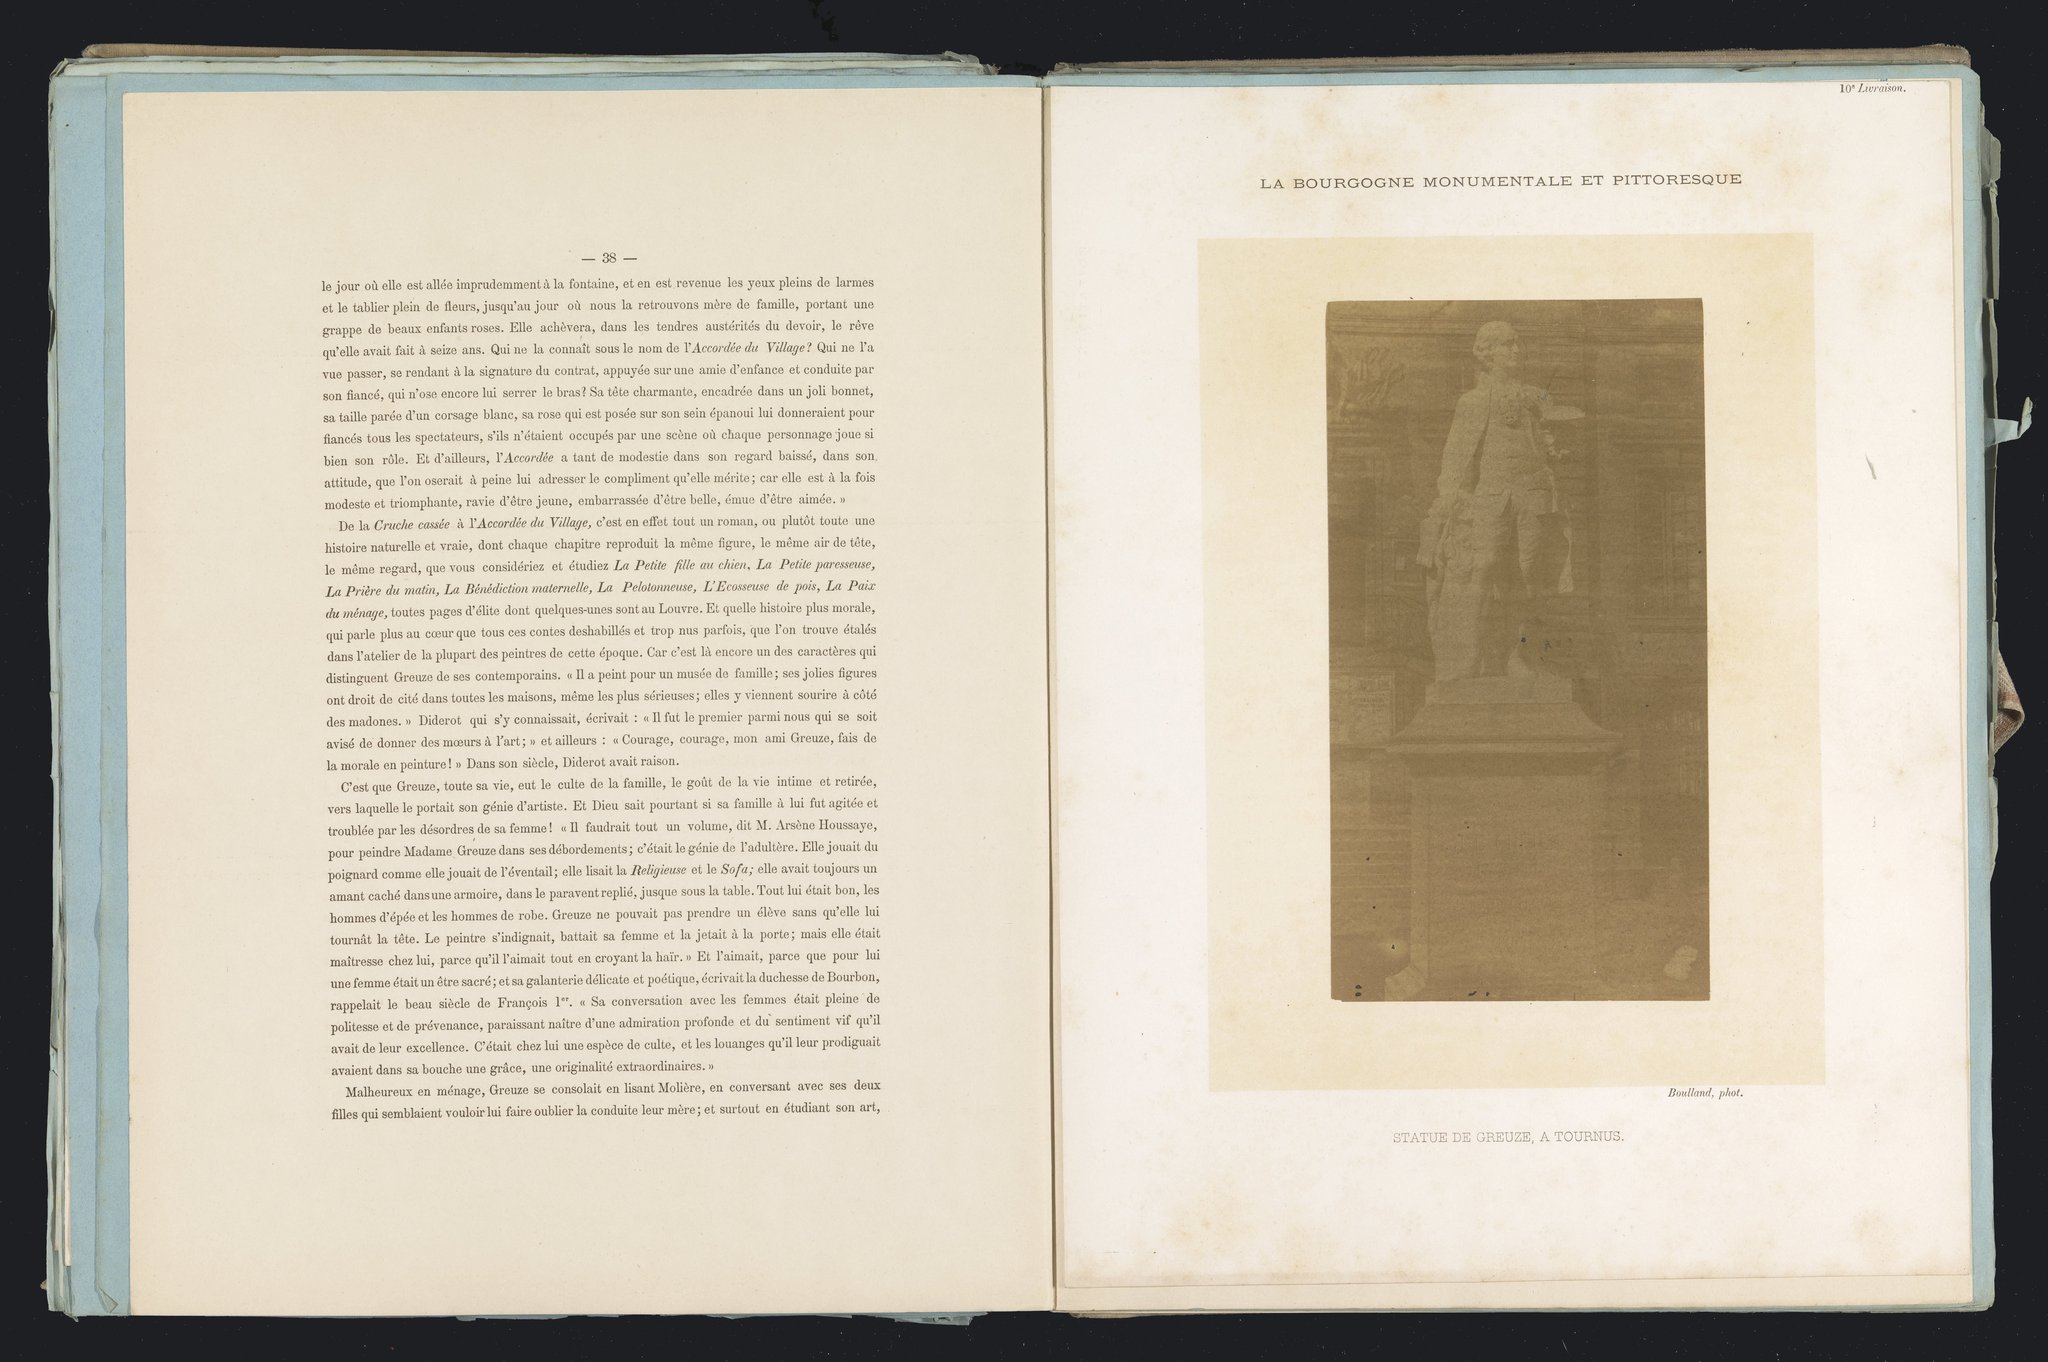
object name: page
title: STATUE DE GREUZE, A TOURNUS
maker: alfred boulland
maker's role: fotograaf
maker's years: 1814-1887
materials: cardboard, photographic support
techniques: albumen print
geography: tournus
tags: paris, painter, jean-baptiste greuze, piece of sculpture, reproduction of a piece of sculpture (+ sculpture), monument, statue